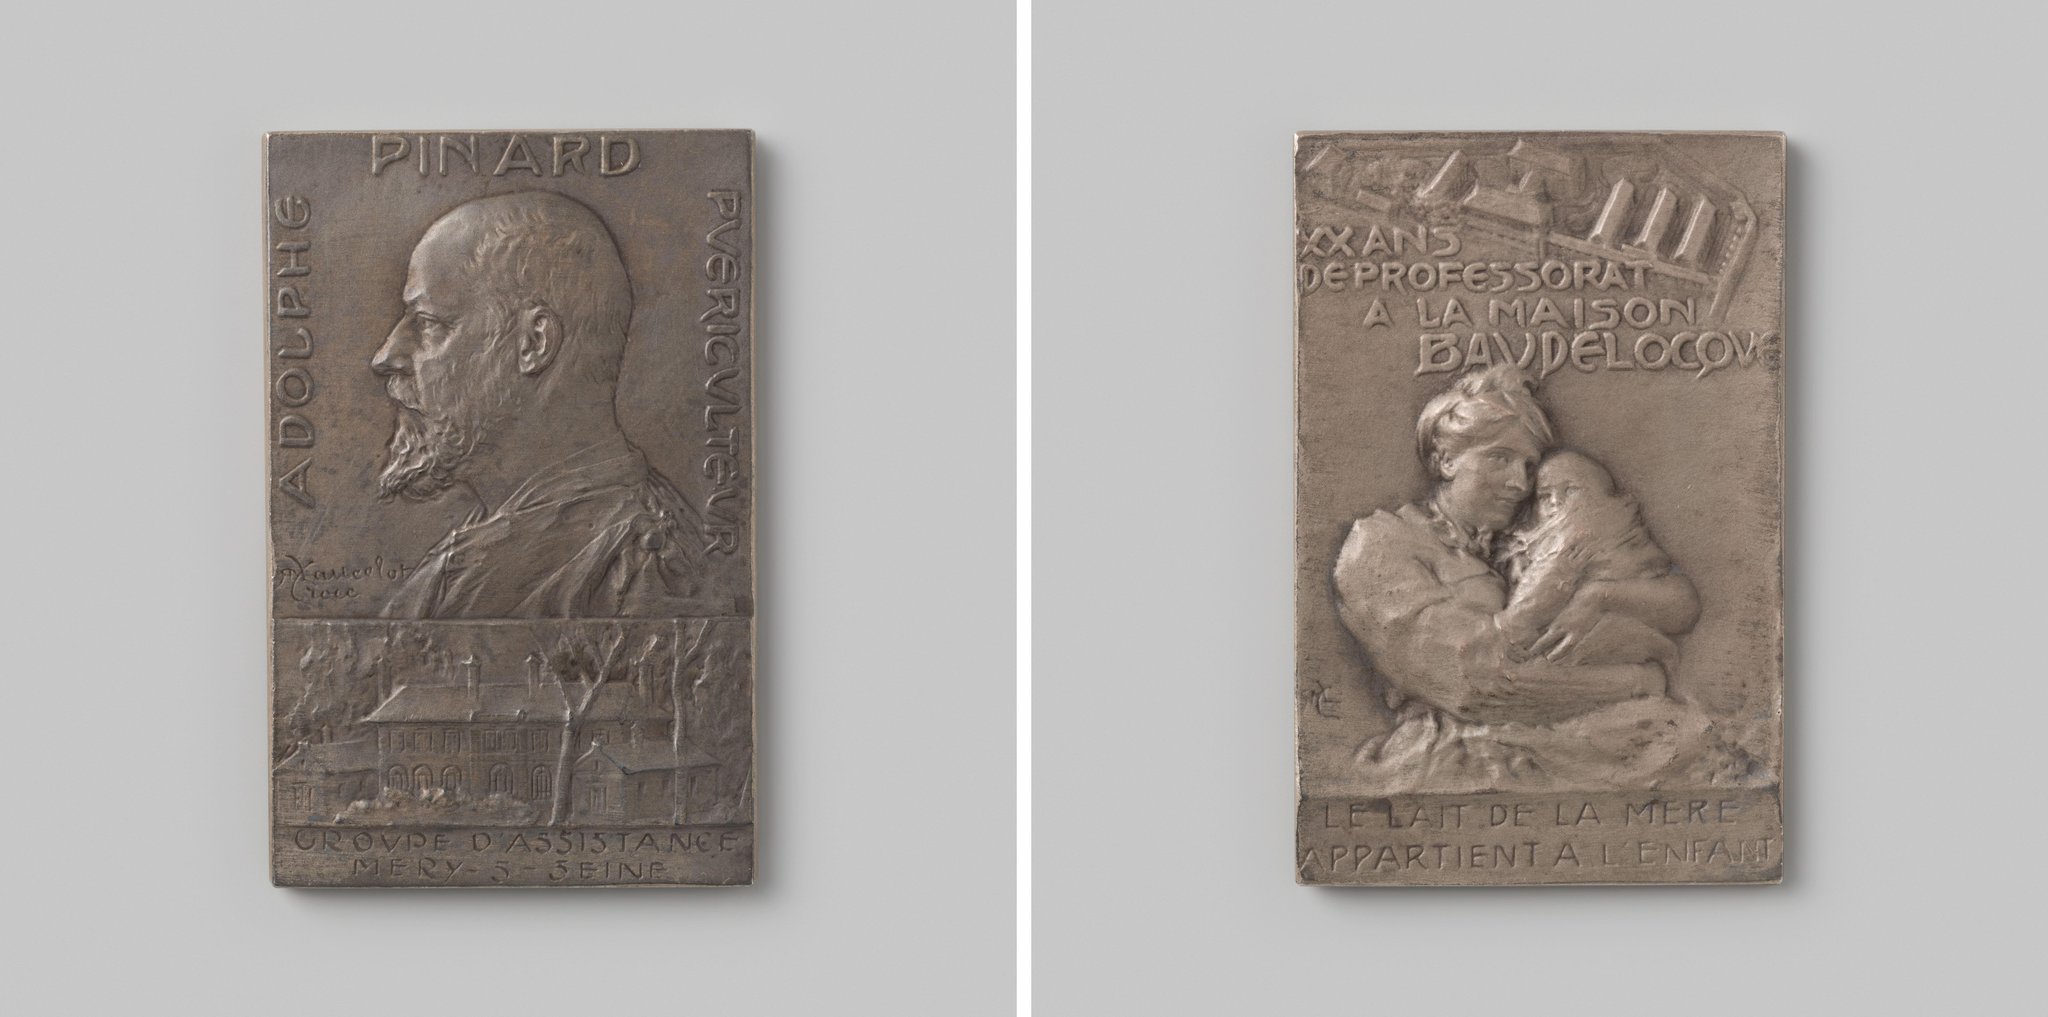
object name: history medal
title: Vijfentwintigjarig professoraat van Adolphe Pinard 1907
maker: marcelle renée lancelot-croce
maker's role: print maker, sculptor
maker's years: 1854-1946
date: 1907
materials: silver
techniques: striking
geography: paris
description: Rechthoekige zilveren plaquette, op de voorzijde het bostbeeld van Pinard naar links met omschrift, boven een band waarop een gebouw met onderschrift, op de keerzijde een vrouw met kind, met onderschrift, waarboven een gebouw in vogelvlucht en vier regels tekst.